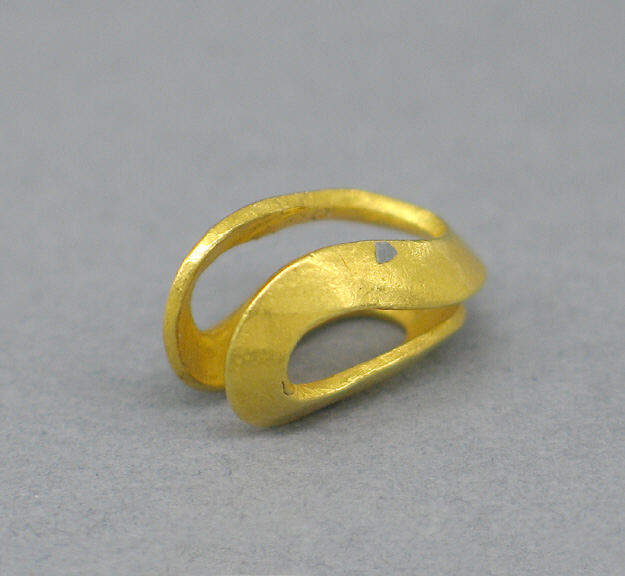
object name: ear clip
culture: indonesian, javanese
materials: gold